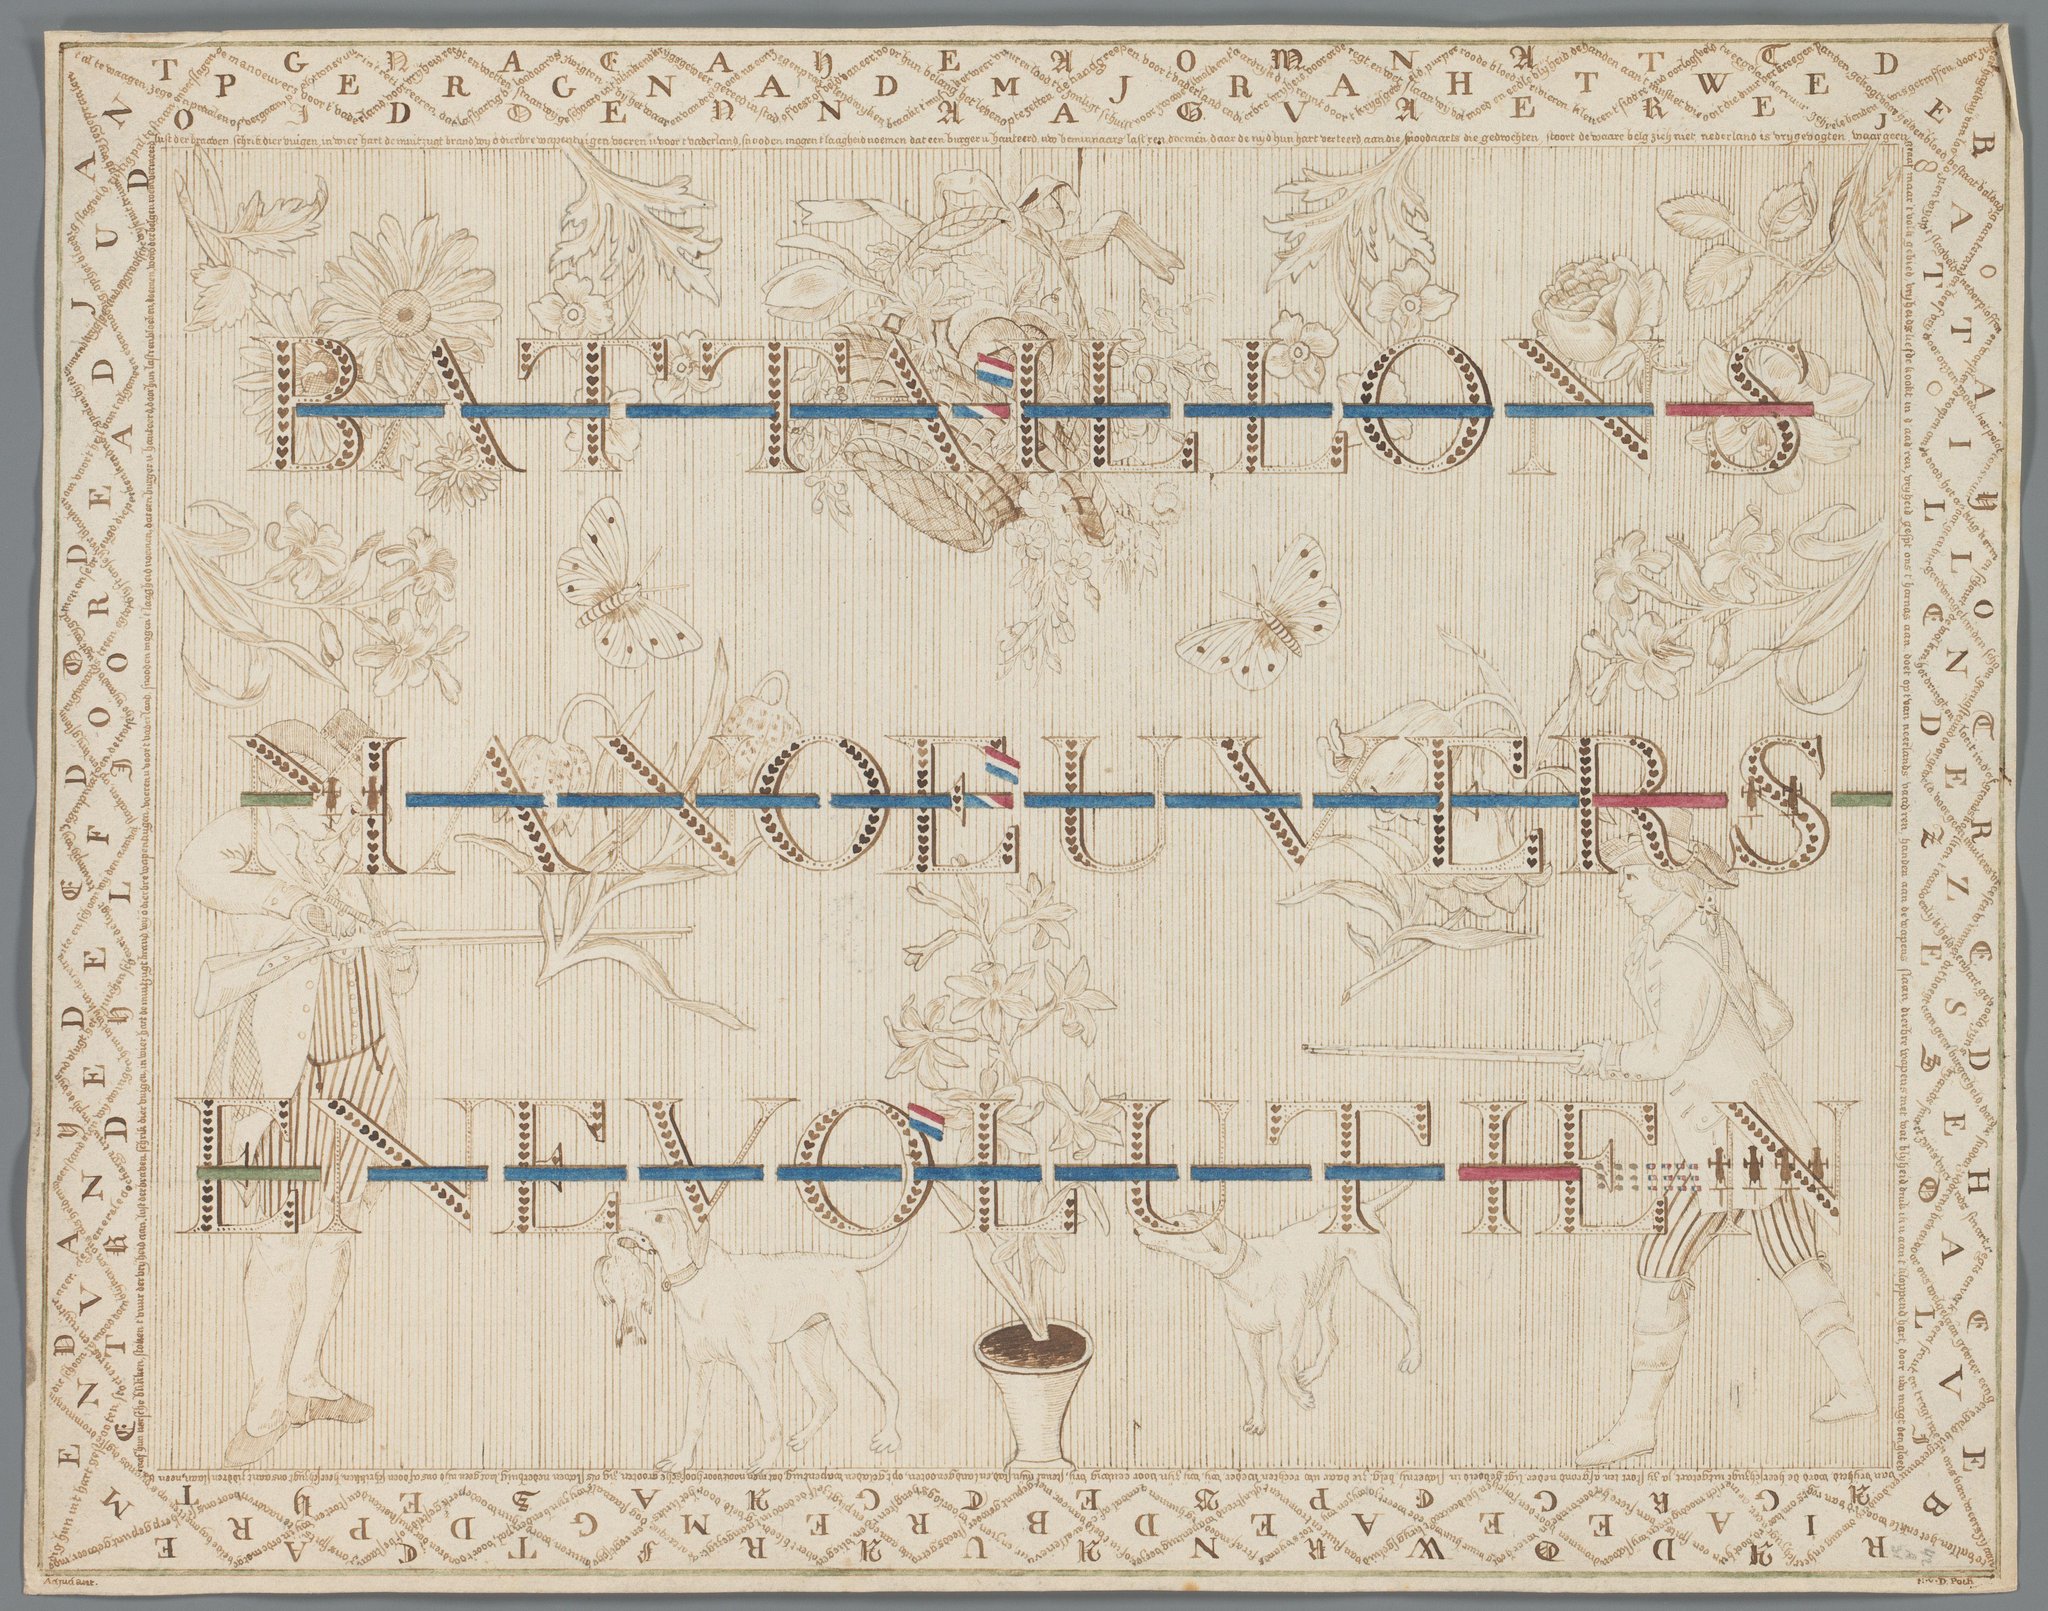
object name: calligraphy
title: Titelblad voor het ensemble, ca. 1799-1803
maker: hendrik van der poth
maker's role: draughtsman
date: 1799-1803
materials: paper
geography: netherlands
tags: flowers, hunters hunting (n.b.: in 1988-1990 this notation denoted the concept of 43c11421 'hunters resting during the hunt'), insects: butterfly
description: Getekende titelblad met gekalligrafeerde titel voor het ensemble van tekeningen en kaarten over de Brits-Russische expeditie naar Noord-Holland in 1799, ca. 1799-1803. Twee soldaten of jagers met jachthonden, het blad versierd met planten, bloemen en insekten. Binnen een kader van letters en teksten waarin de opdracht staat 'Aan de Majoor van het Tweede Battaillon der Zesde Halve Brigade Gewapende Burgermagt Departement van Delf'.